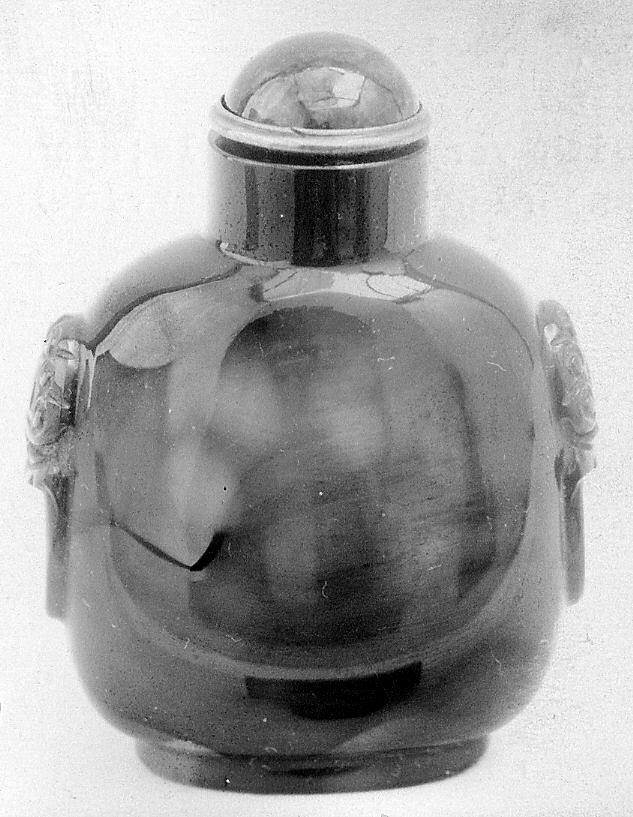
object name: snuff bottle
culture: chinese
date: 1736-1795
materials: gemstone